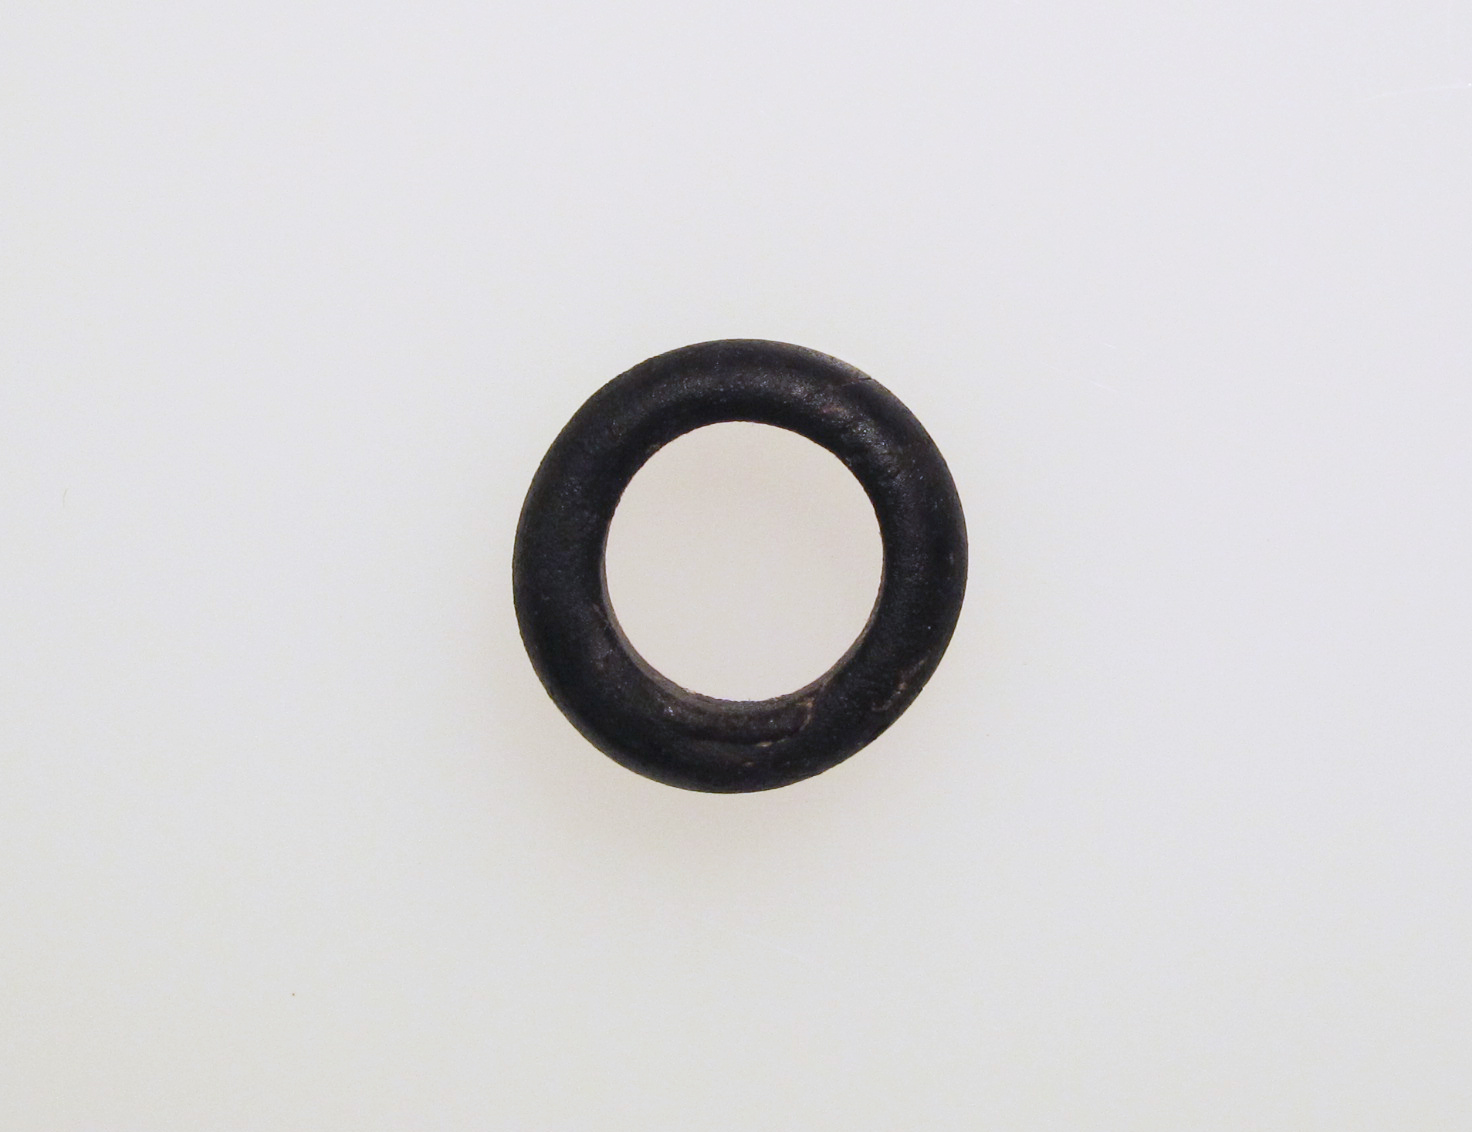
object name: bead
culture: roman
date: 670 BCE-330 CE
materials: glass